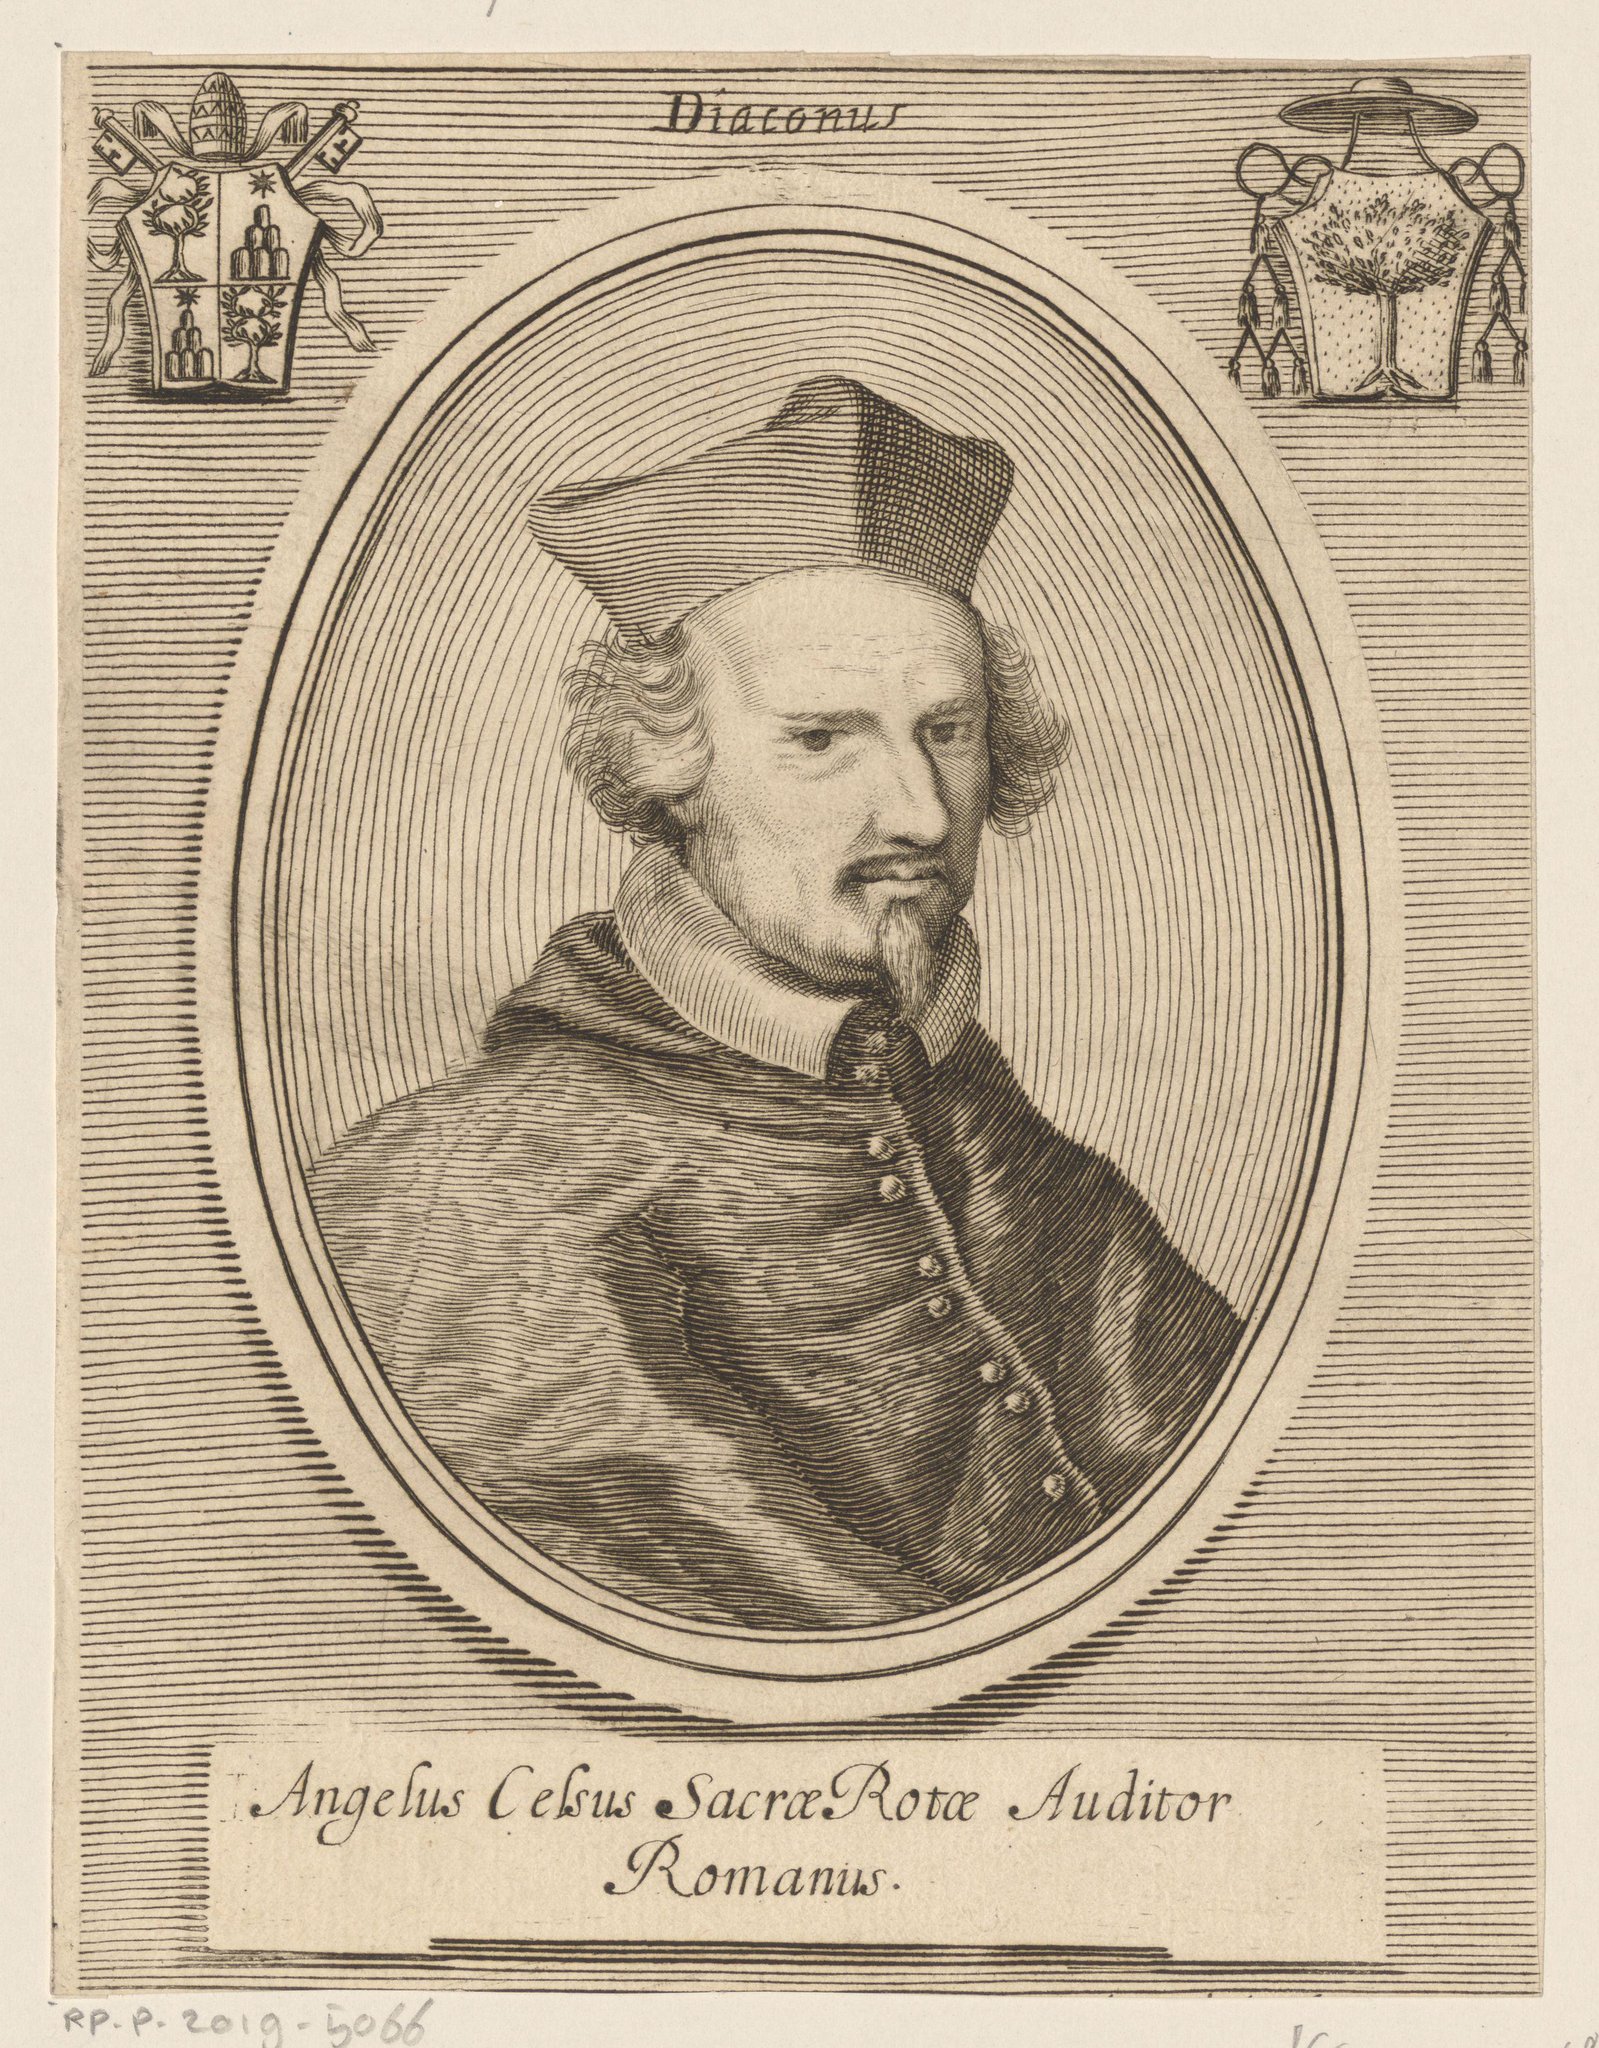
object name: print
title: Portret van kardinaal Angelo Celsi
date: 1664-1691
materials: paper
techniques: engraving, etching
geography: rome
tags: rome, cardinal, historical persons, armorial bearing, heraldry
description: Met rechtsboven zijn wapenschild en linksboven het wapen van paus Alexander VII.